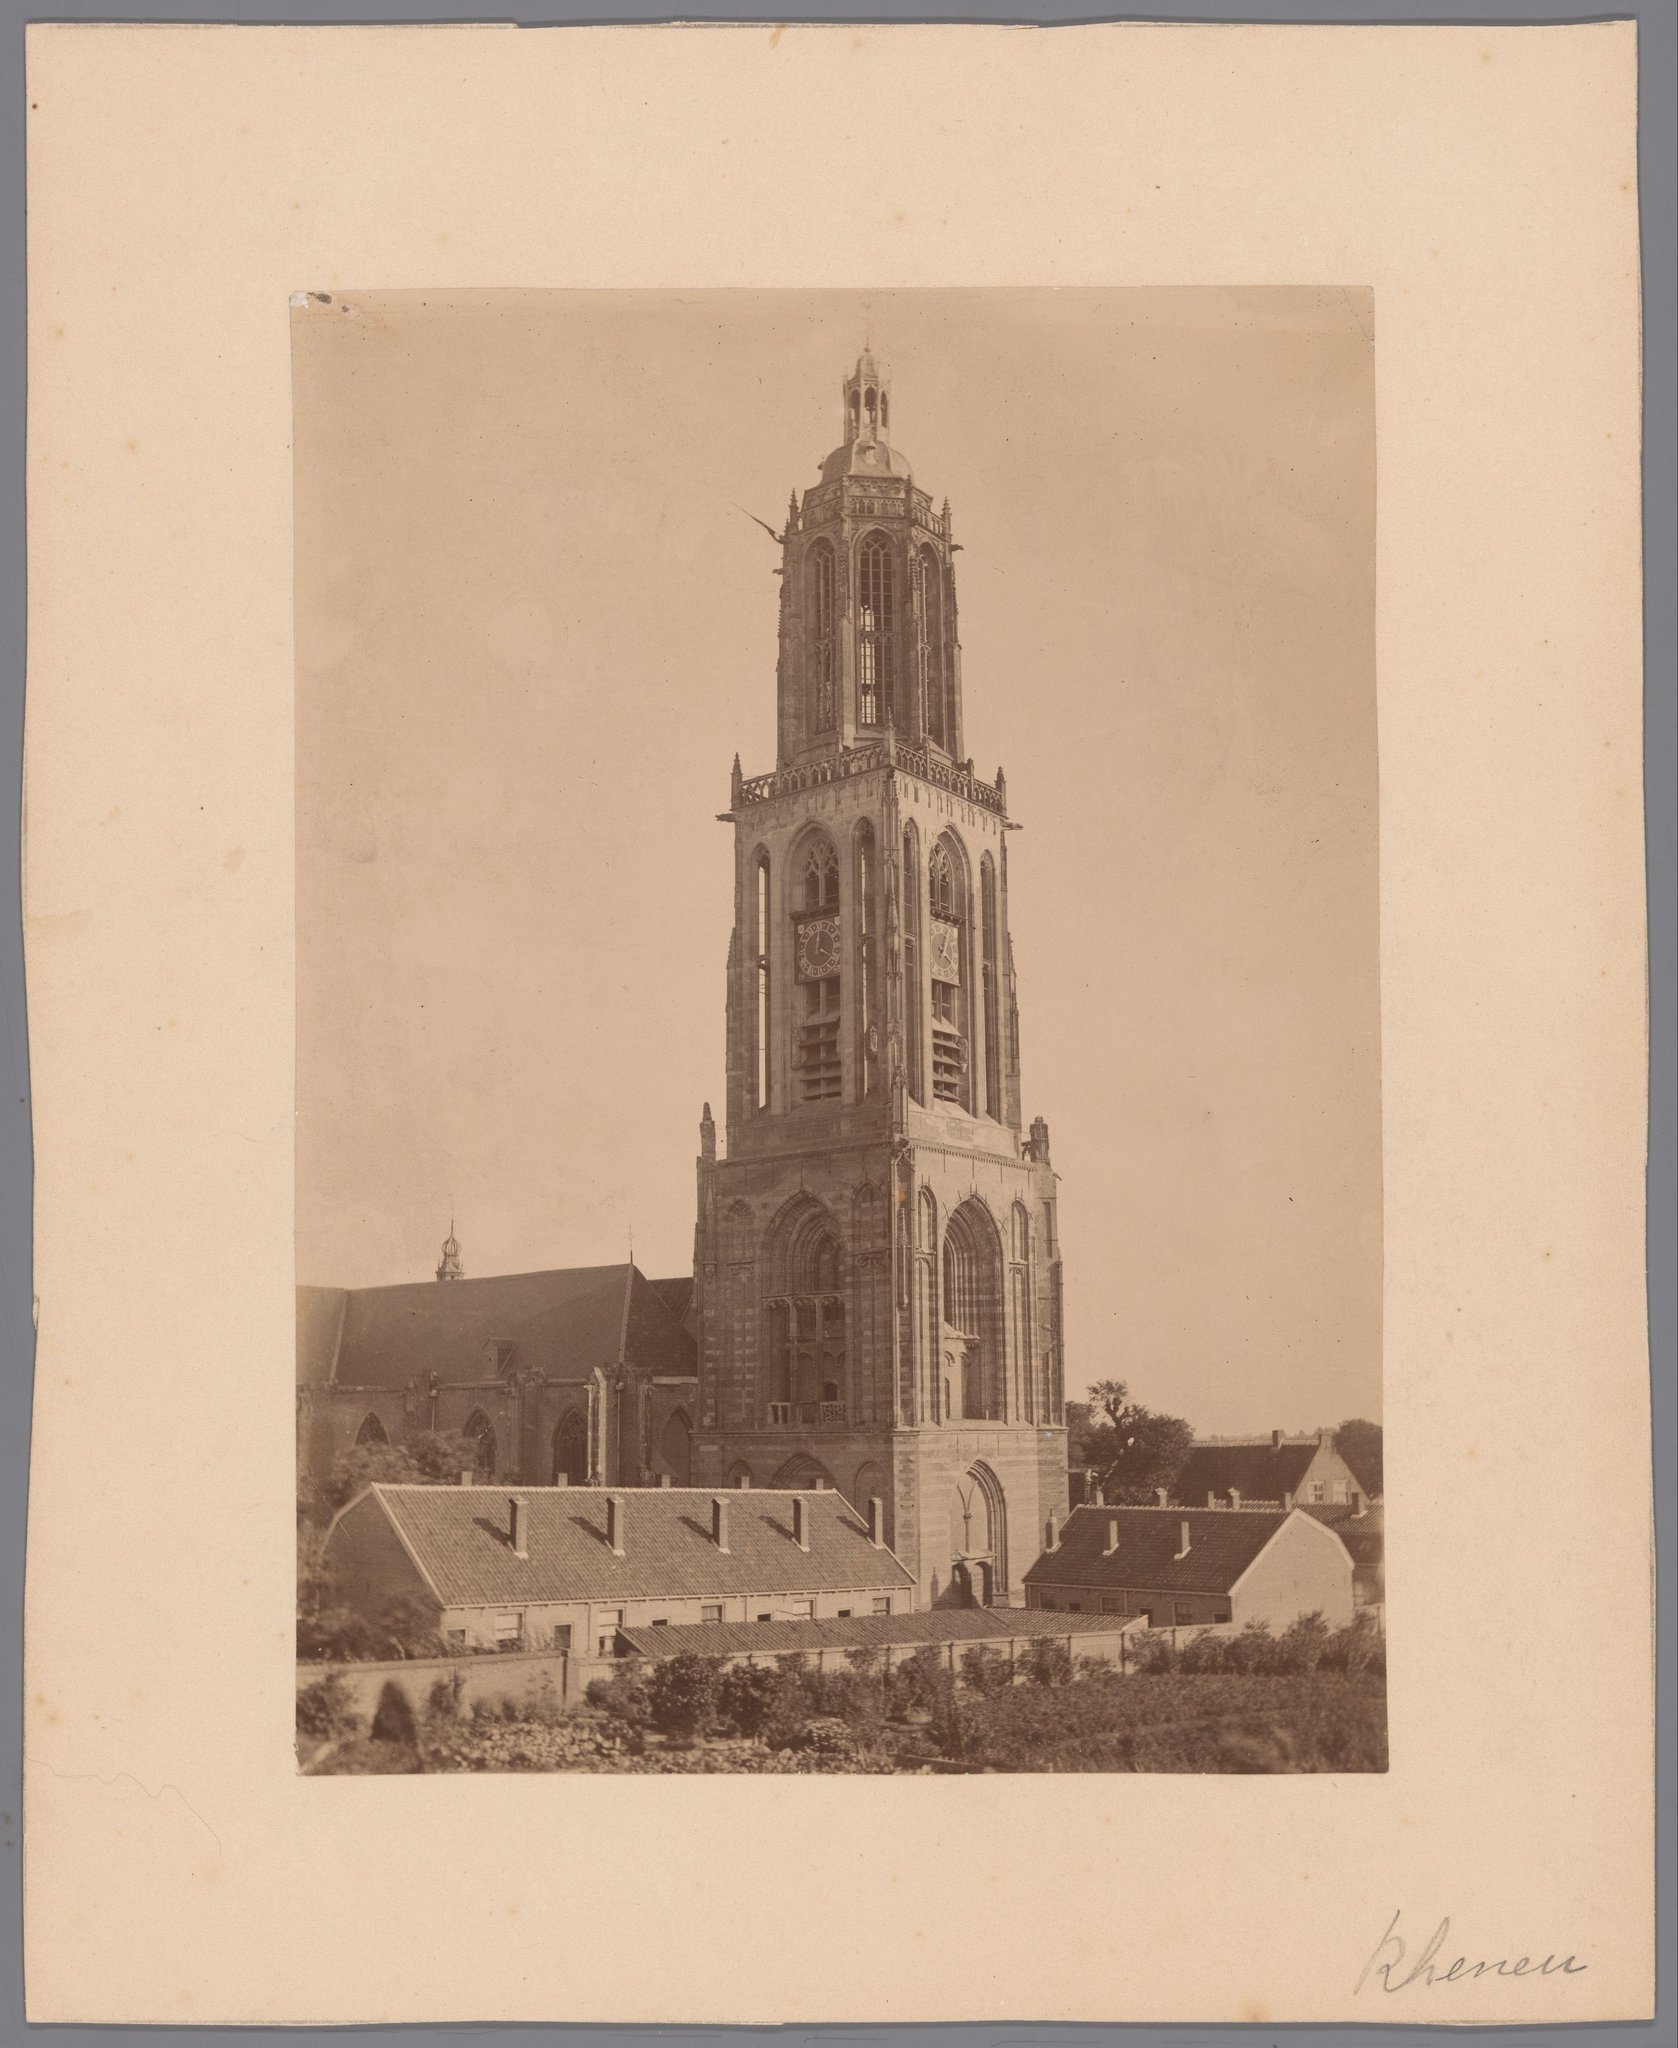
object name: photograph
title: Toren van de Cunerakerk te Rhenen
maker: anoniem (monumentenzorg)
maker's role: fotograaf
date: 1909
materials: cardboard, photographic support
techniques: gelatin silver print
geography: rhenen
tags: parts of church exterior and annexes: tower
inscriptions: annotation: ‘De Cunerakerk te Rhenen (...)’, annotation: ‘Rhenen’